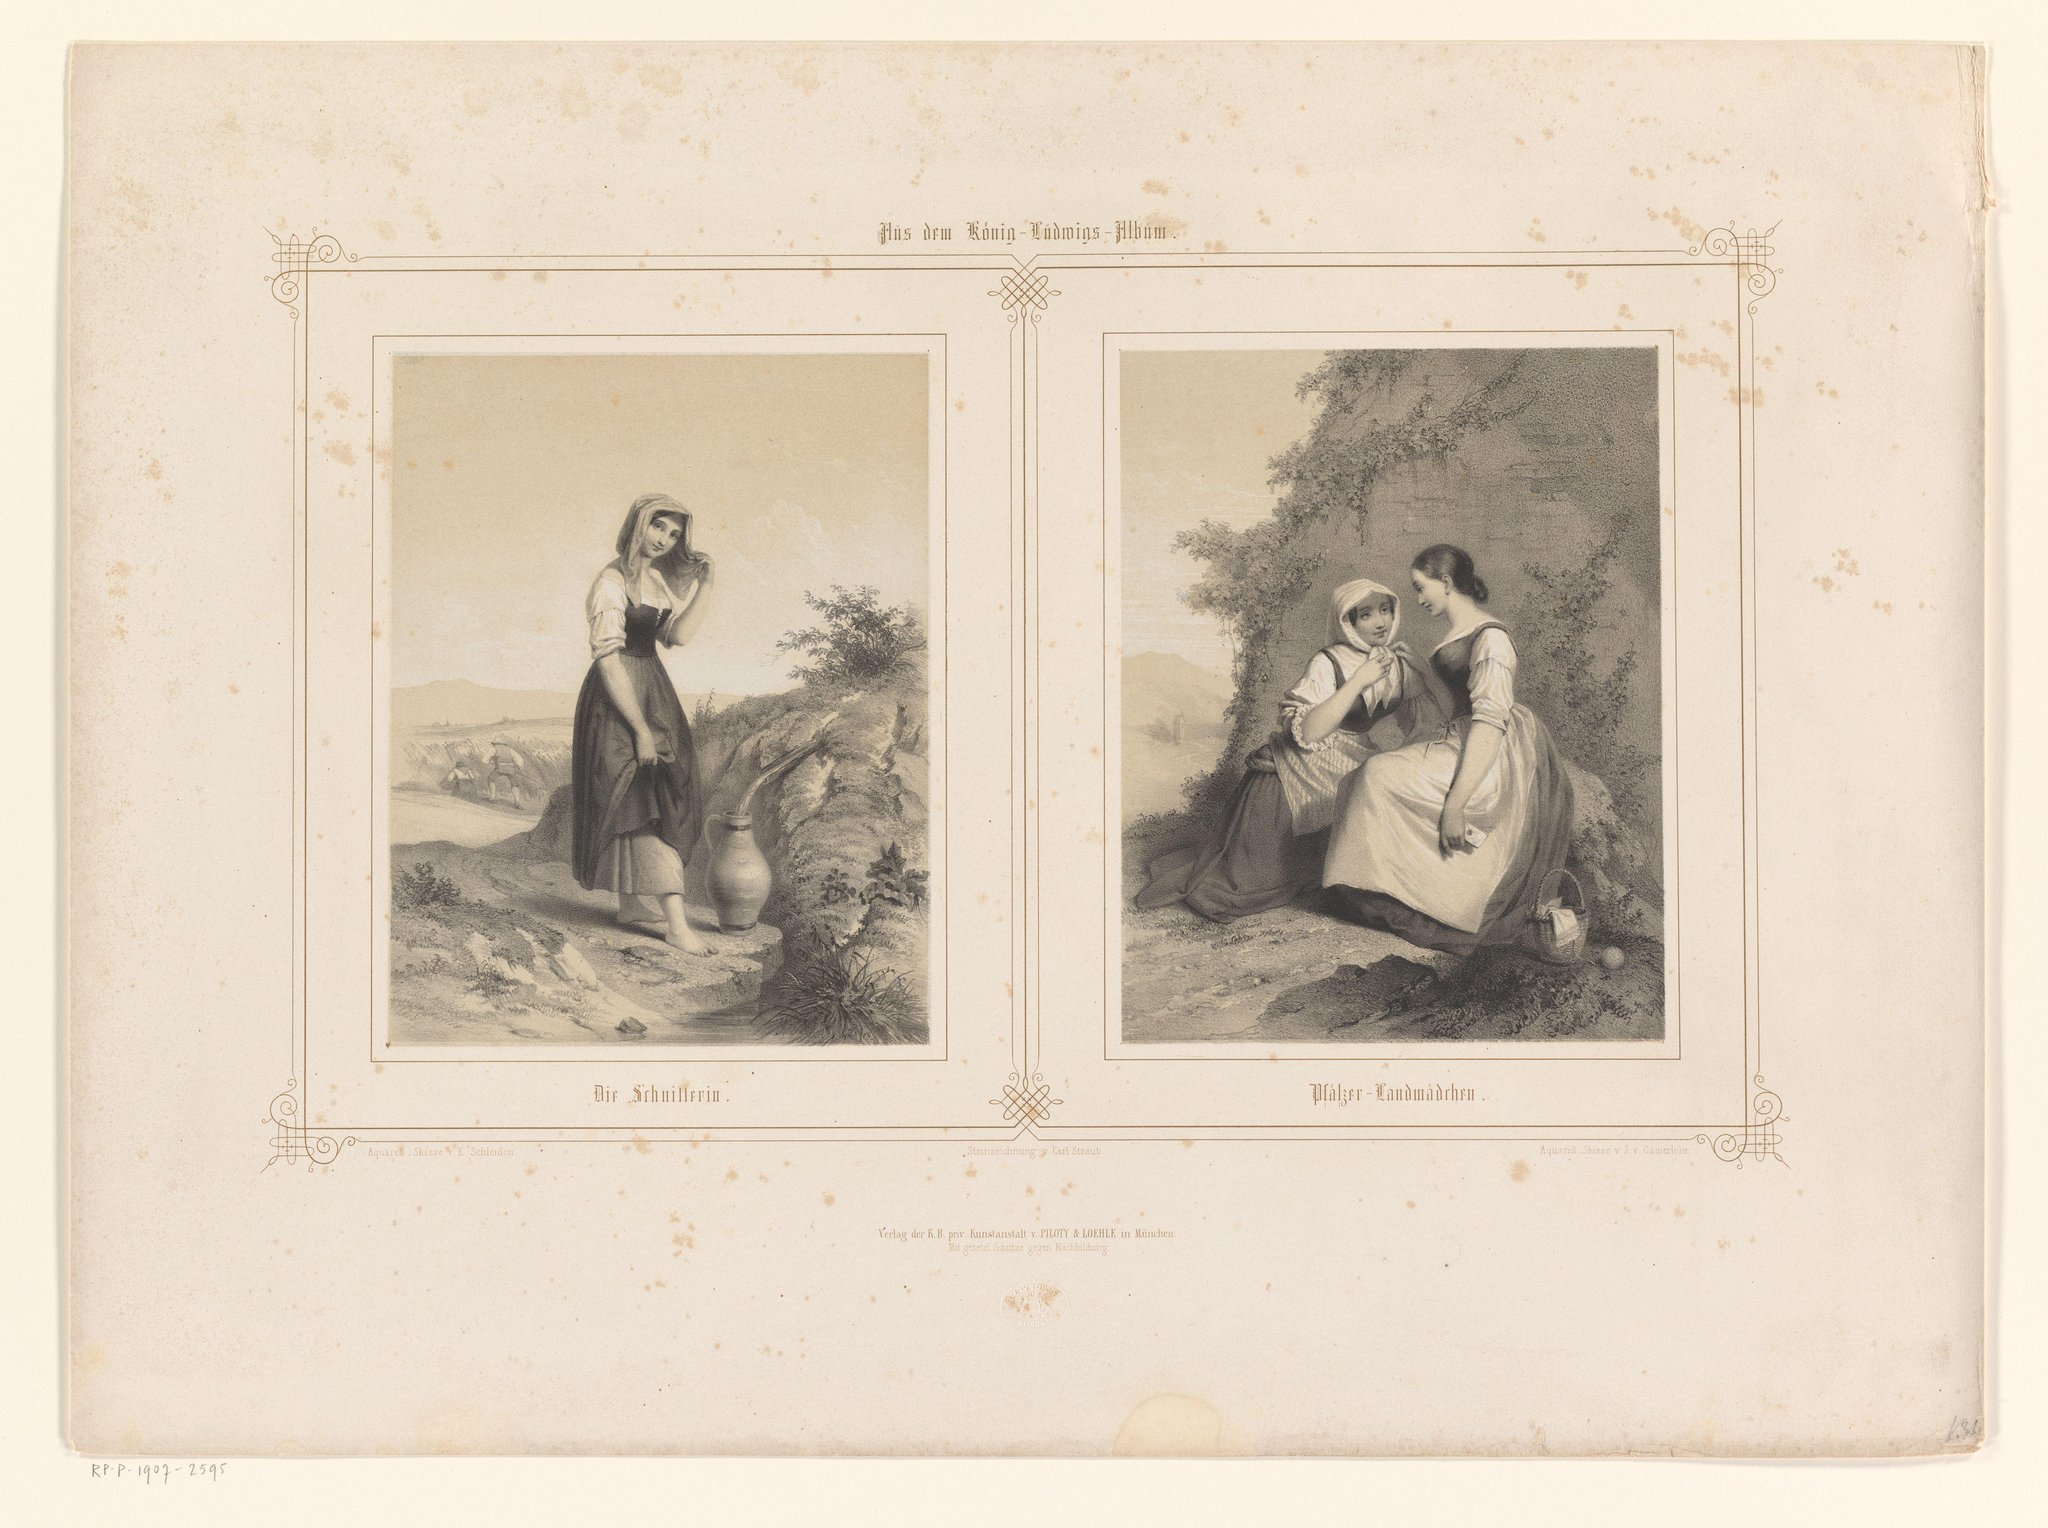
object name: print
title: König-Ludwigs Album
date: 1850-1859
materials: paper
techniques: tone lithography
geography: munich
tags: adolescent, young woman, maiden (+ three persons), landscapes (+ landscape with figures, staffage)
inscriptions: collector's mark: Lugt 2228, : ‘Mit gesetzl Schutze gegen Nachbildung’, check stamp: ‘Piloty&Loehle, München’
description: Prent afkomstig uit de serie 'Album Seiner Majestät des Königs Ludwig I. von Bayern', verschenen in verschillende afleveringen. De prenten gaan terug op het album dat Lodewijk I van Beieren op 9 oktober 1850 kreeg overhandigd van verschillende kunstenaars.